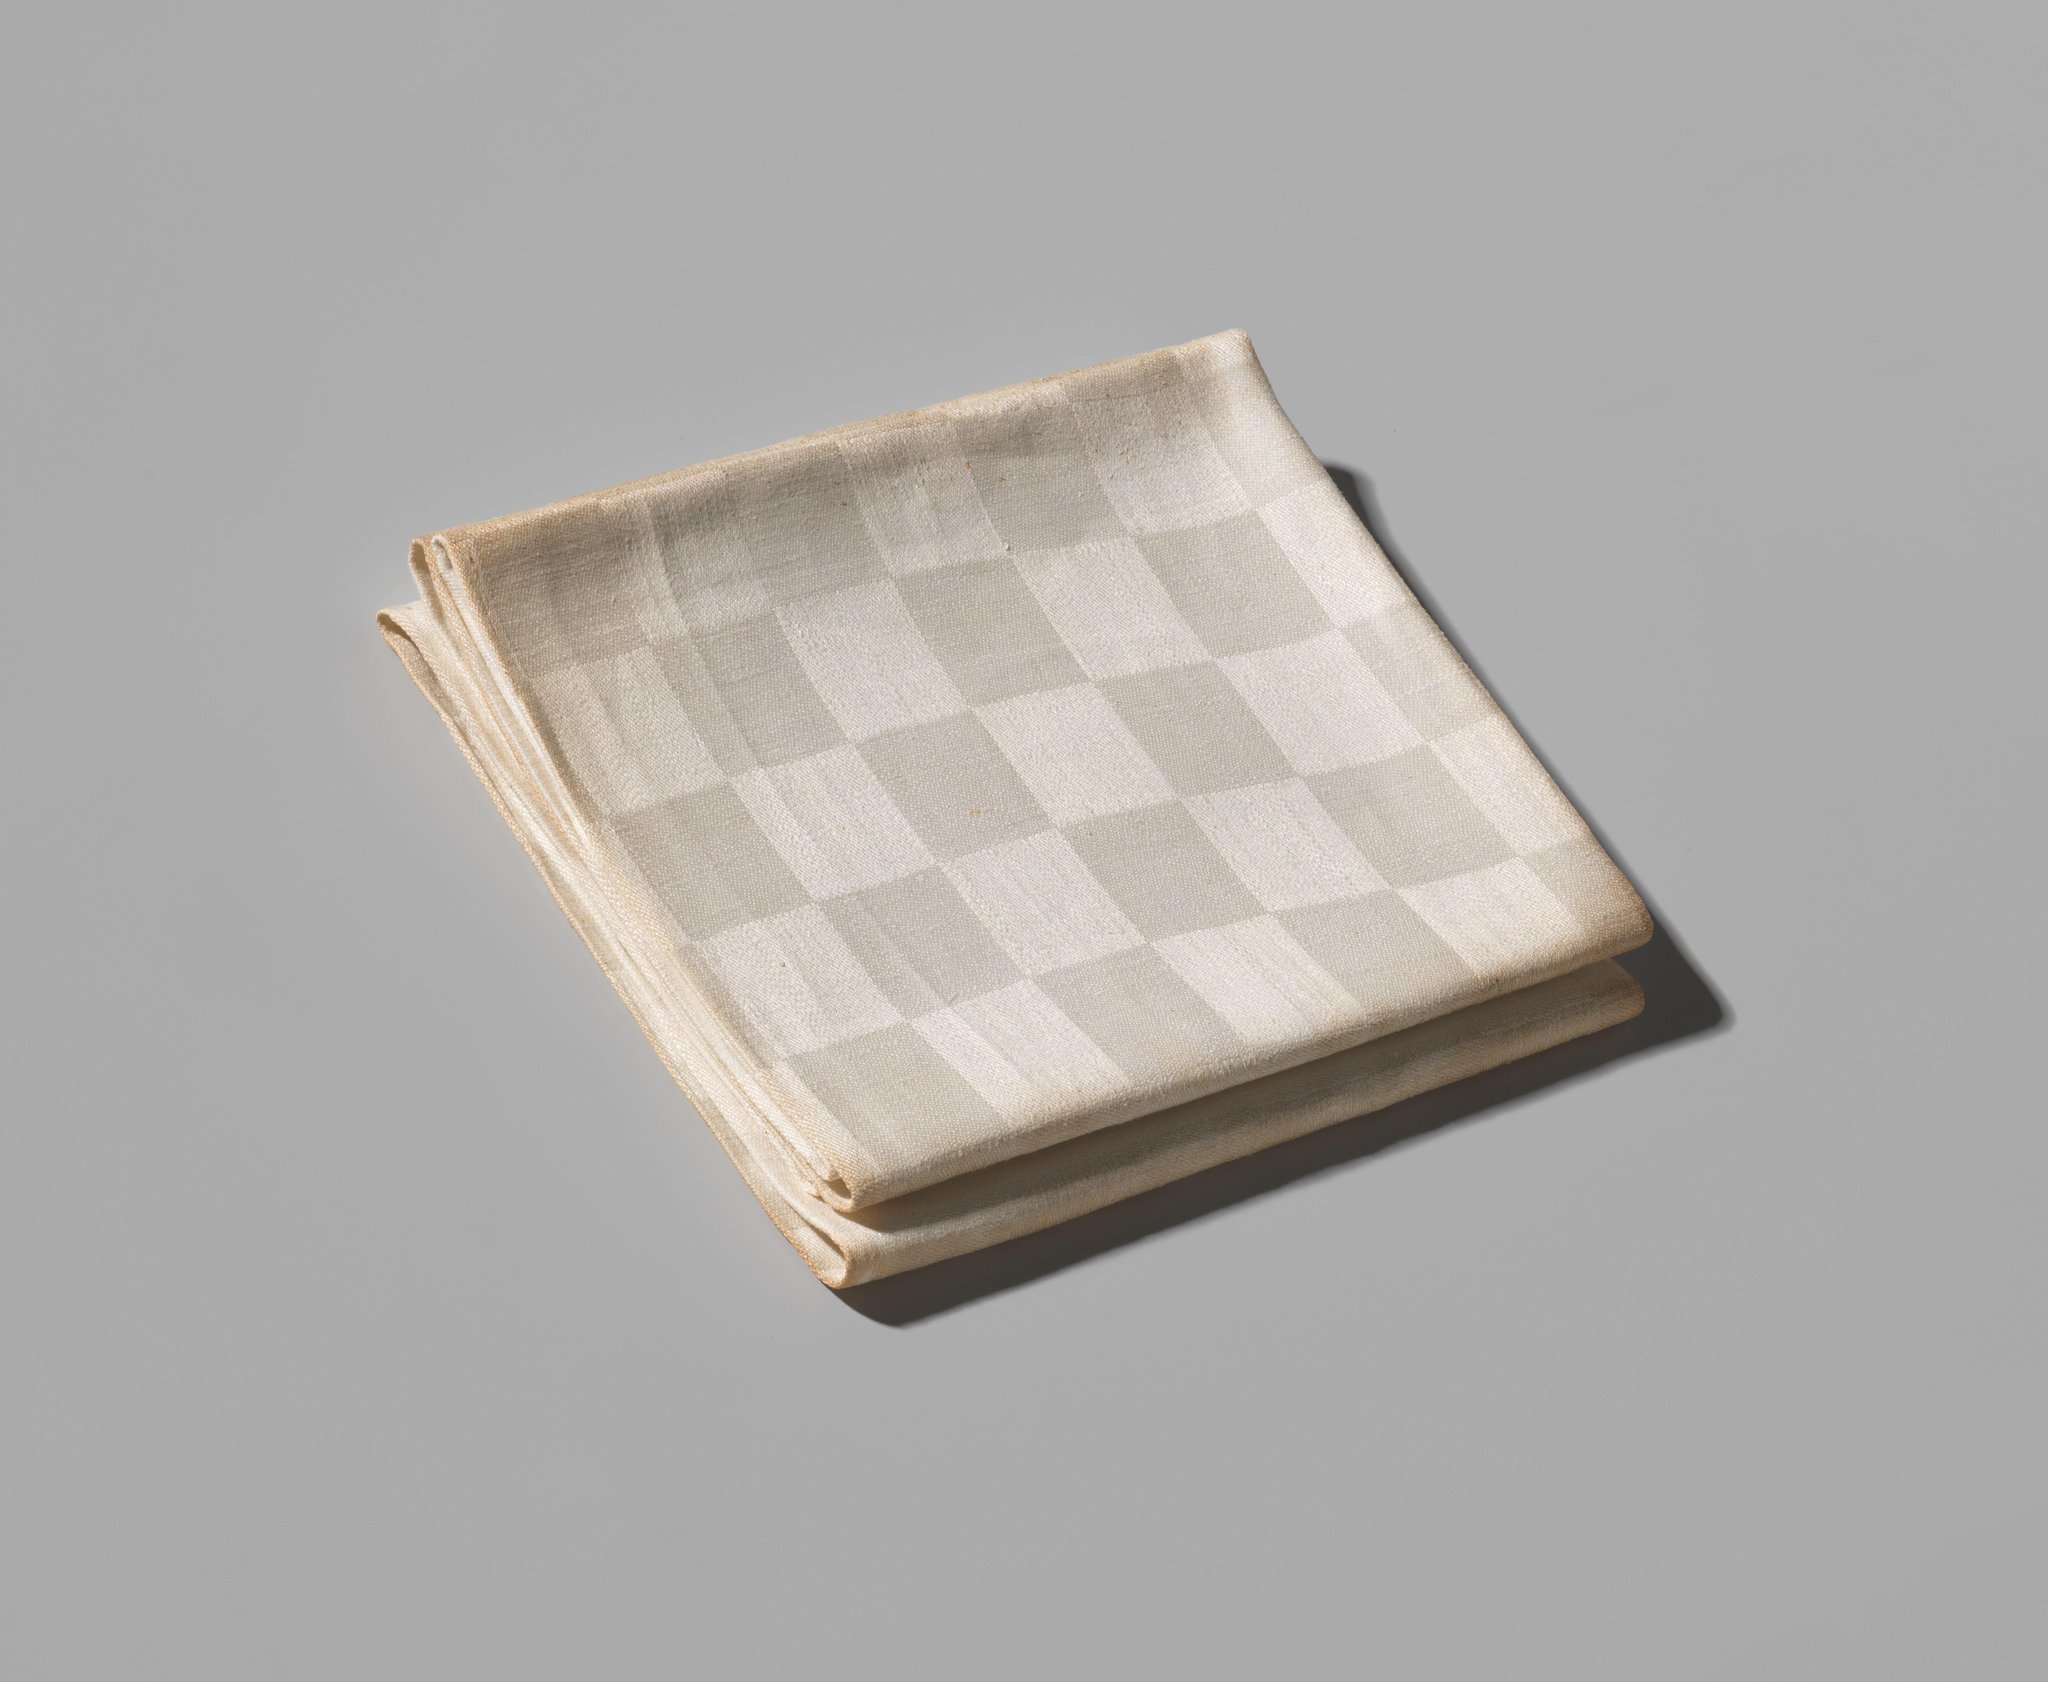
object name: towel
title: Doek van linnen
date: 1800-1870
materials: linen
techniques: peeled fabric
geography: netherlands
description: Handdoek of doek voor keukengebruik van linnen, pellen, blok. Restanten van lussen en linten.